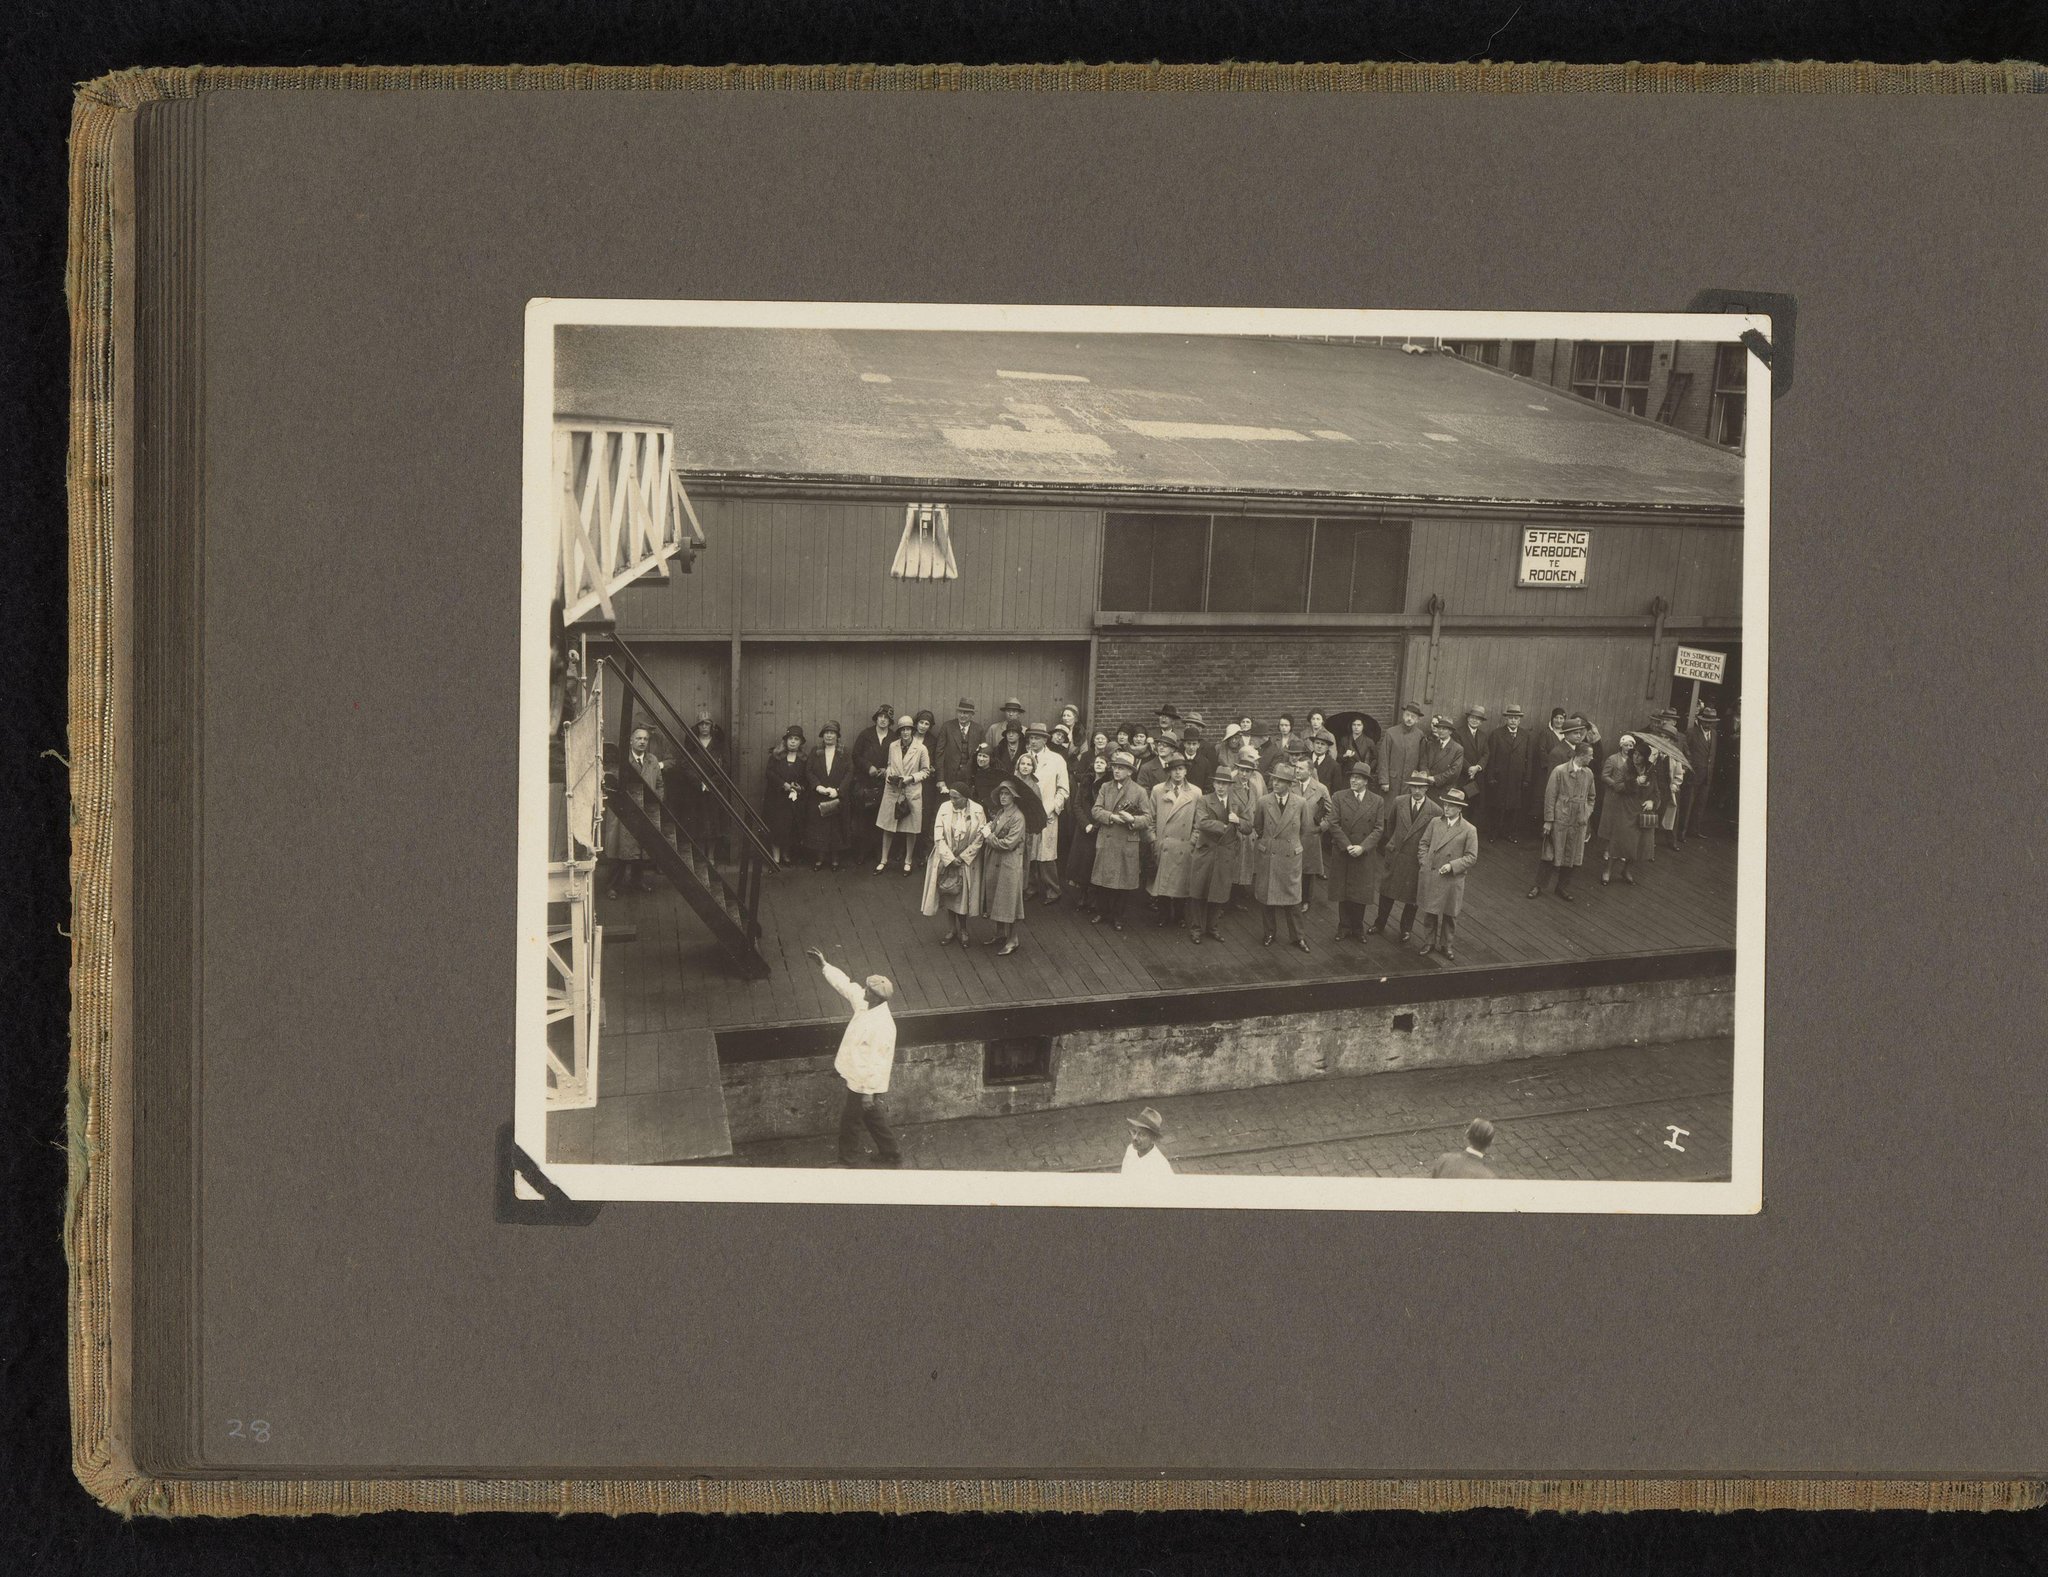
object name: album leaf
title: Op de kade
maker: Anonymous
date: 1930-1931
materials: cardboard, photographic support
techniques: gelatin silver print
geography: netherlands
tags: pier, quay, wharf, netherlands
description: Albumblad met een foto van een groep mensen wachtend op de kade. Onderdeel van fotoalbum 'Studentenalbum Indologen'.